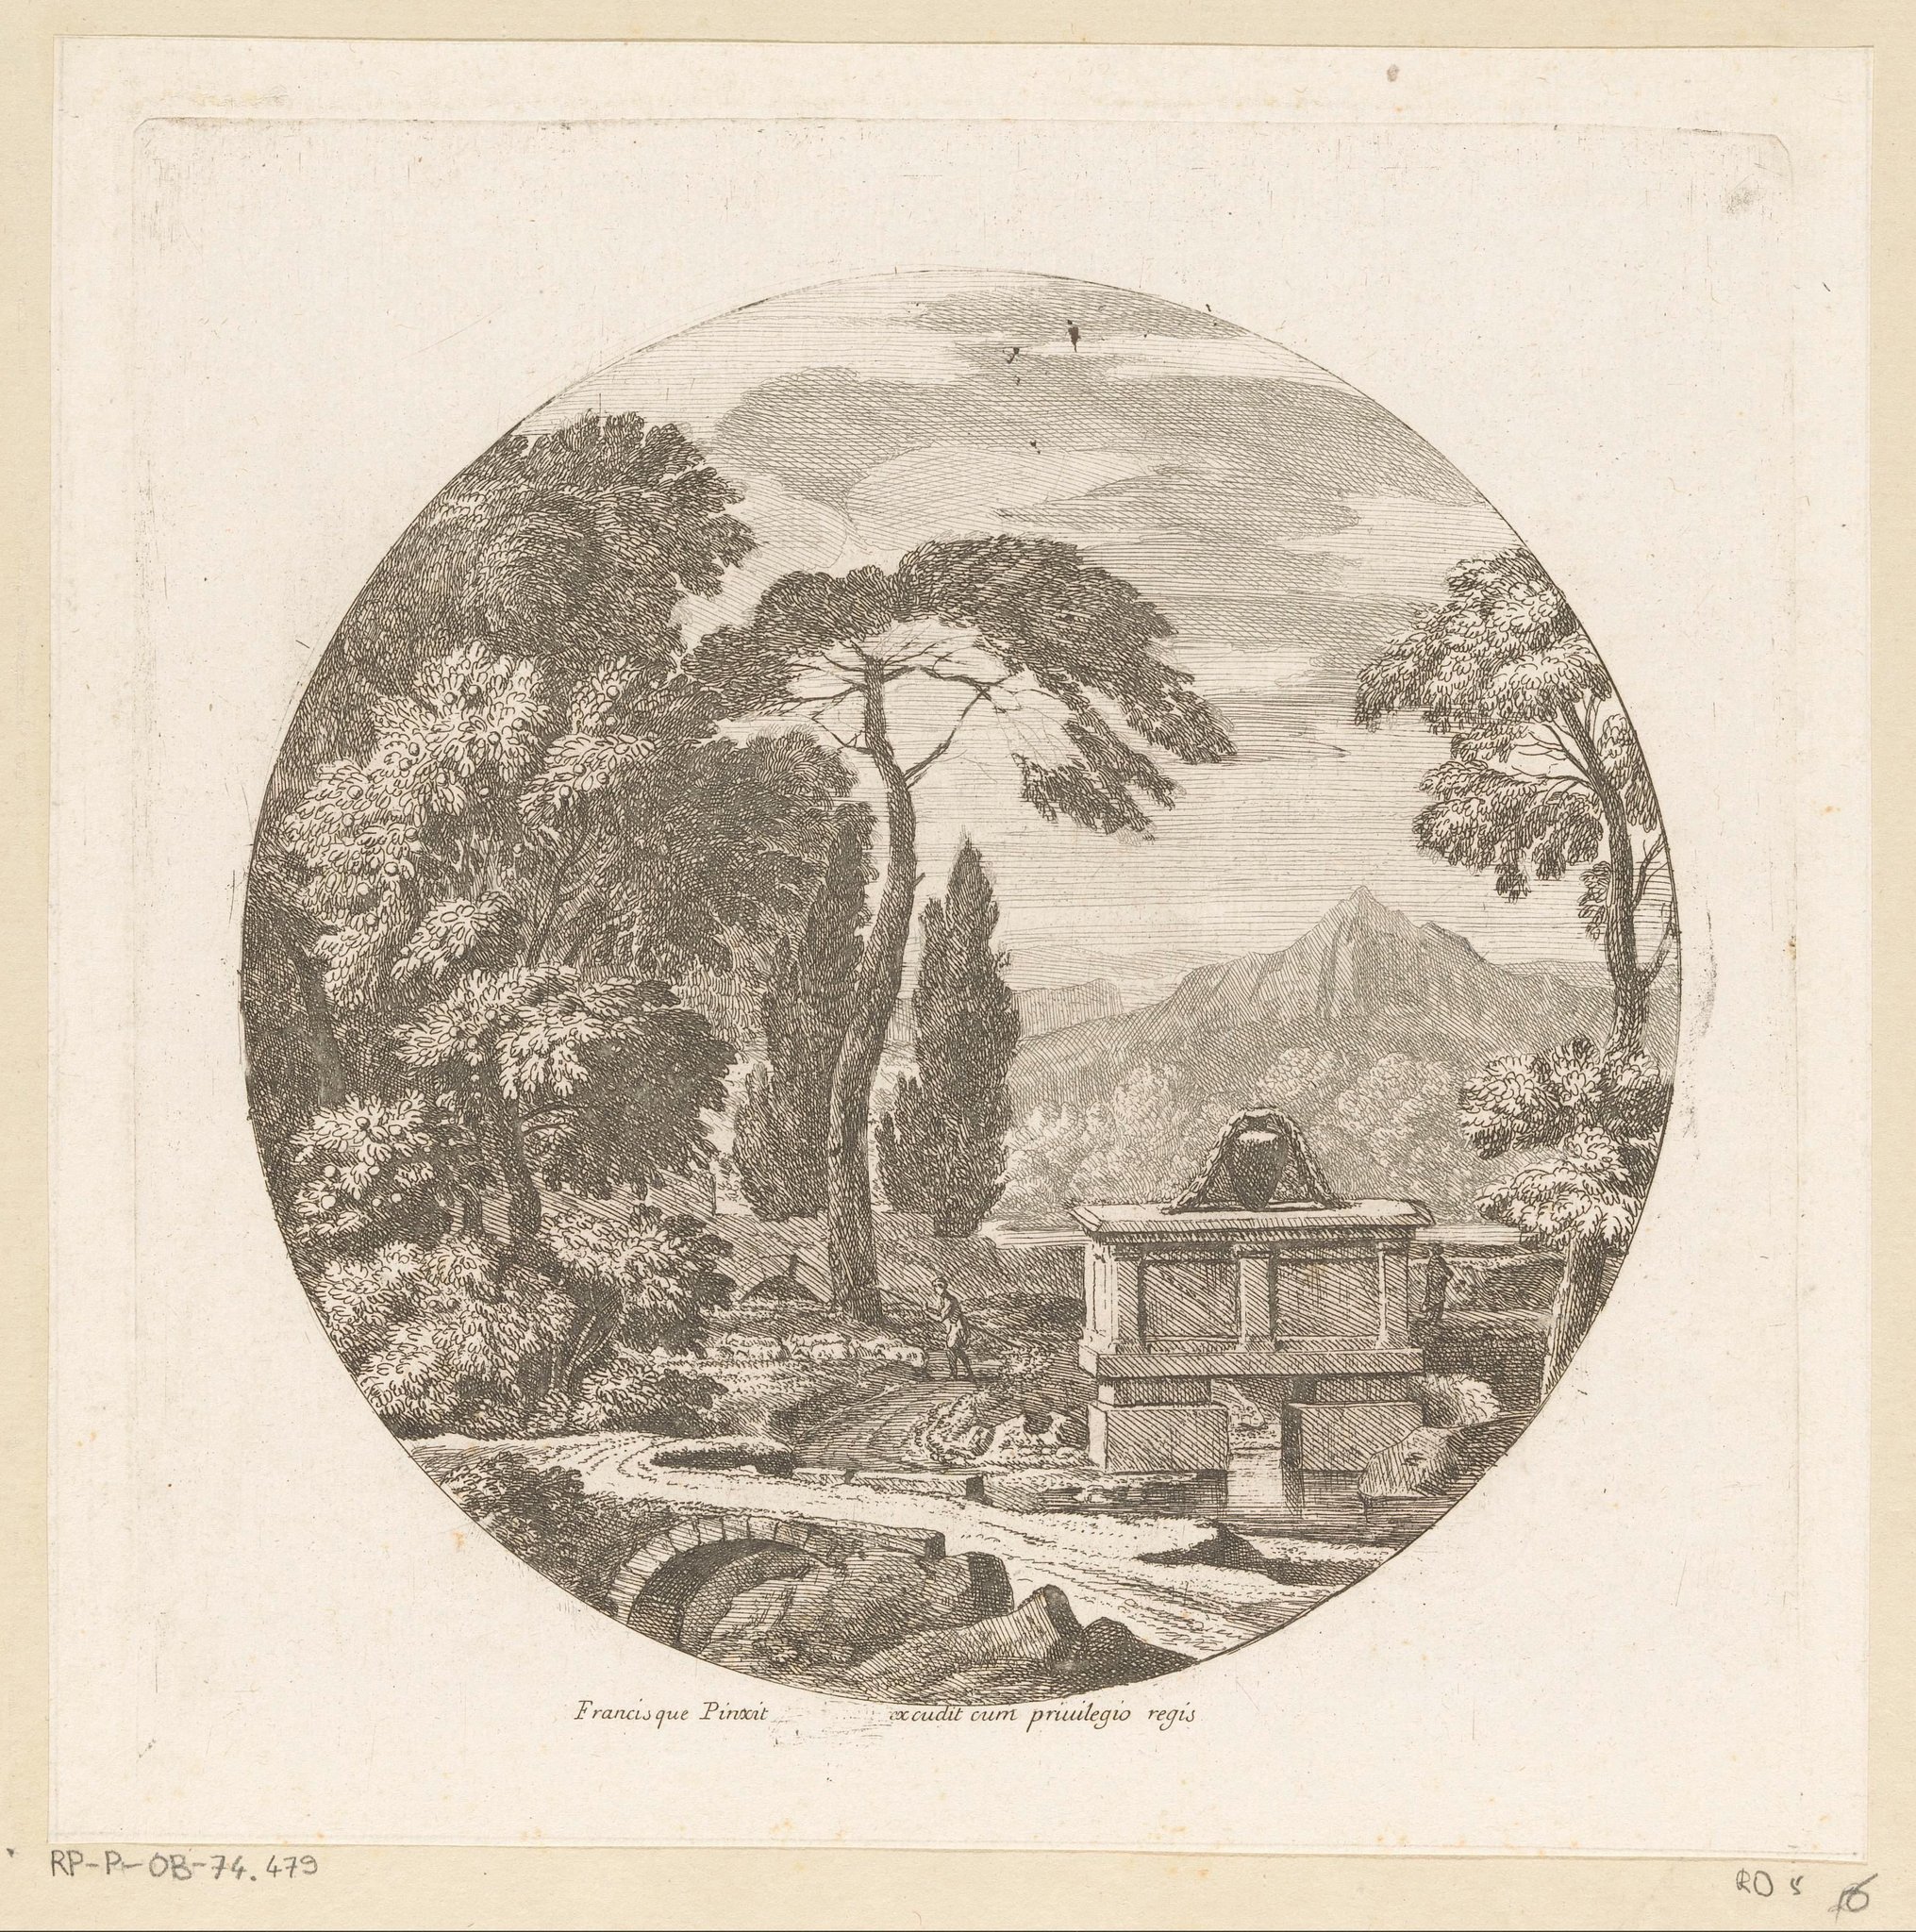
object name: print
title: Arcadisch landschap met een sarcofaag langs een bospad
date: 1690-1730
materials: paper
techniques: etching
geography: france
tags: landscapes in the temperate zone - hh - ideal landscapes, sarcophagus, forest path or lane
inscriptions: collector's mark: Lugt 240